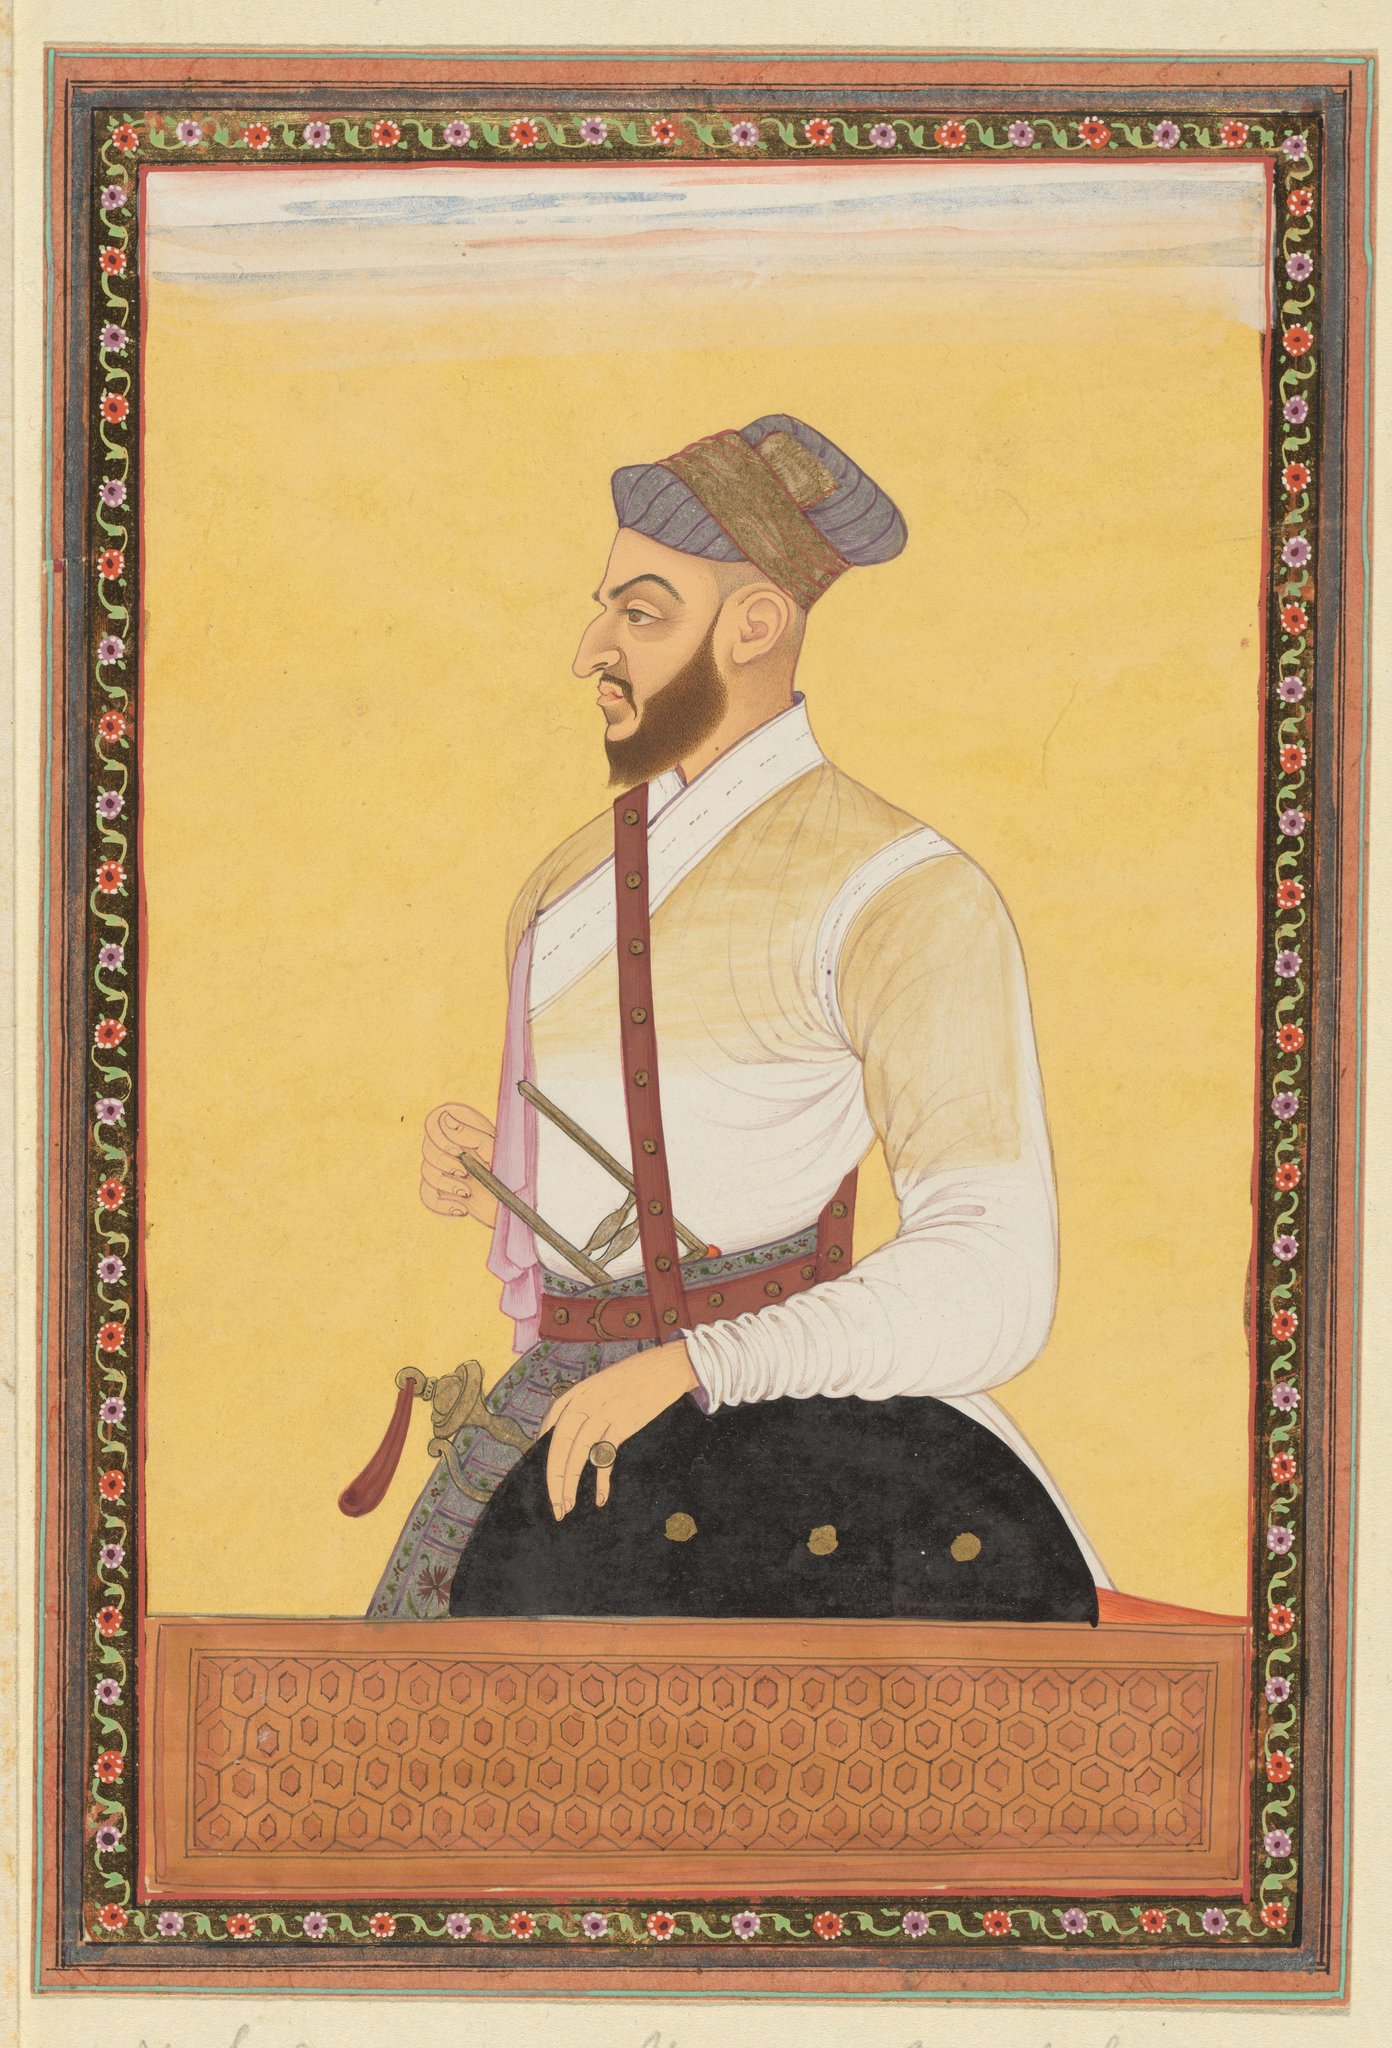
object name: indian miniature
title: Portret van Saf-shikan Khan die vizier van Aurangzeb is geweest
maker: Anonymous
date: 1686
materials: paint, gold leaf, gouache, paper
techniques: brush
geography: golkonda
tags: amsterdam, print maker, mayor, nicolaes cornelisz. witsen, historical person (...) - historical person (...) portrayed alone, ruler, sovereign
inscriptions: collector's mark: Lugt 1838, annotation: ‘Zaf-Seghen-Chan, Visir van Orangh Sieb’, collector's mark: Lugt 240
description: Saf-shikan Khan is tot aan zijn heupen afgebeeld, naar links gewend, met zijn linker arm op een schild aan zijn zijde, zijn rechter hand op een in zijn gordel gestoken kattan. Blad 18 in het `Witsen-Album', met 49 Indiase miniaturen van vorsten. Boven het portret een stukje papier met de naam in het Perzisch. Onder het portret een stukje papier met de naam in het Portugees.